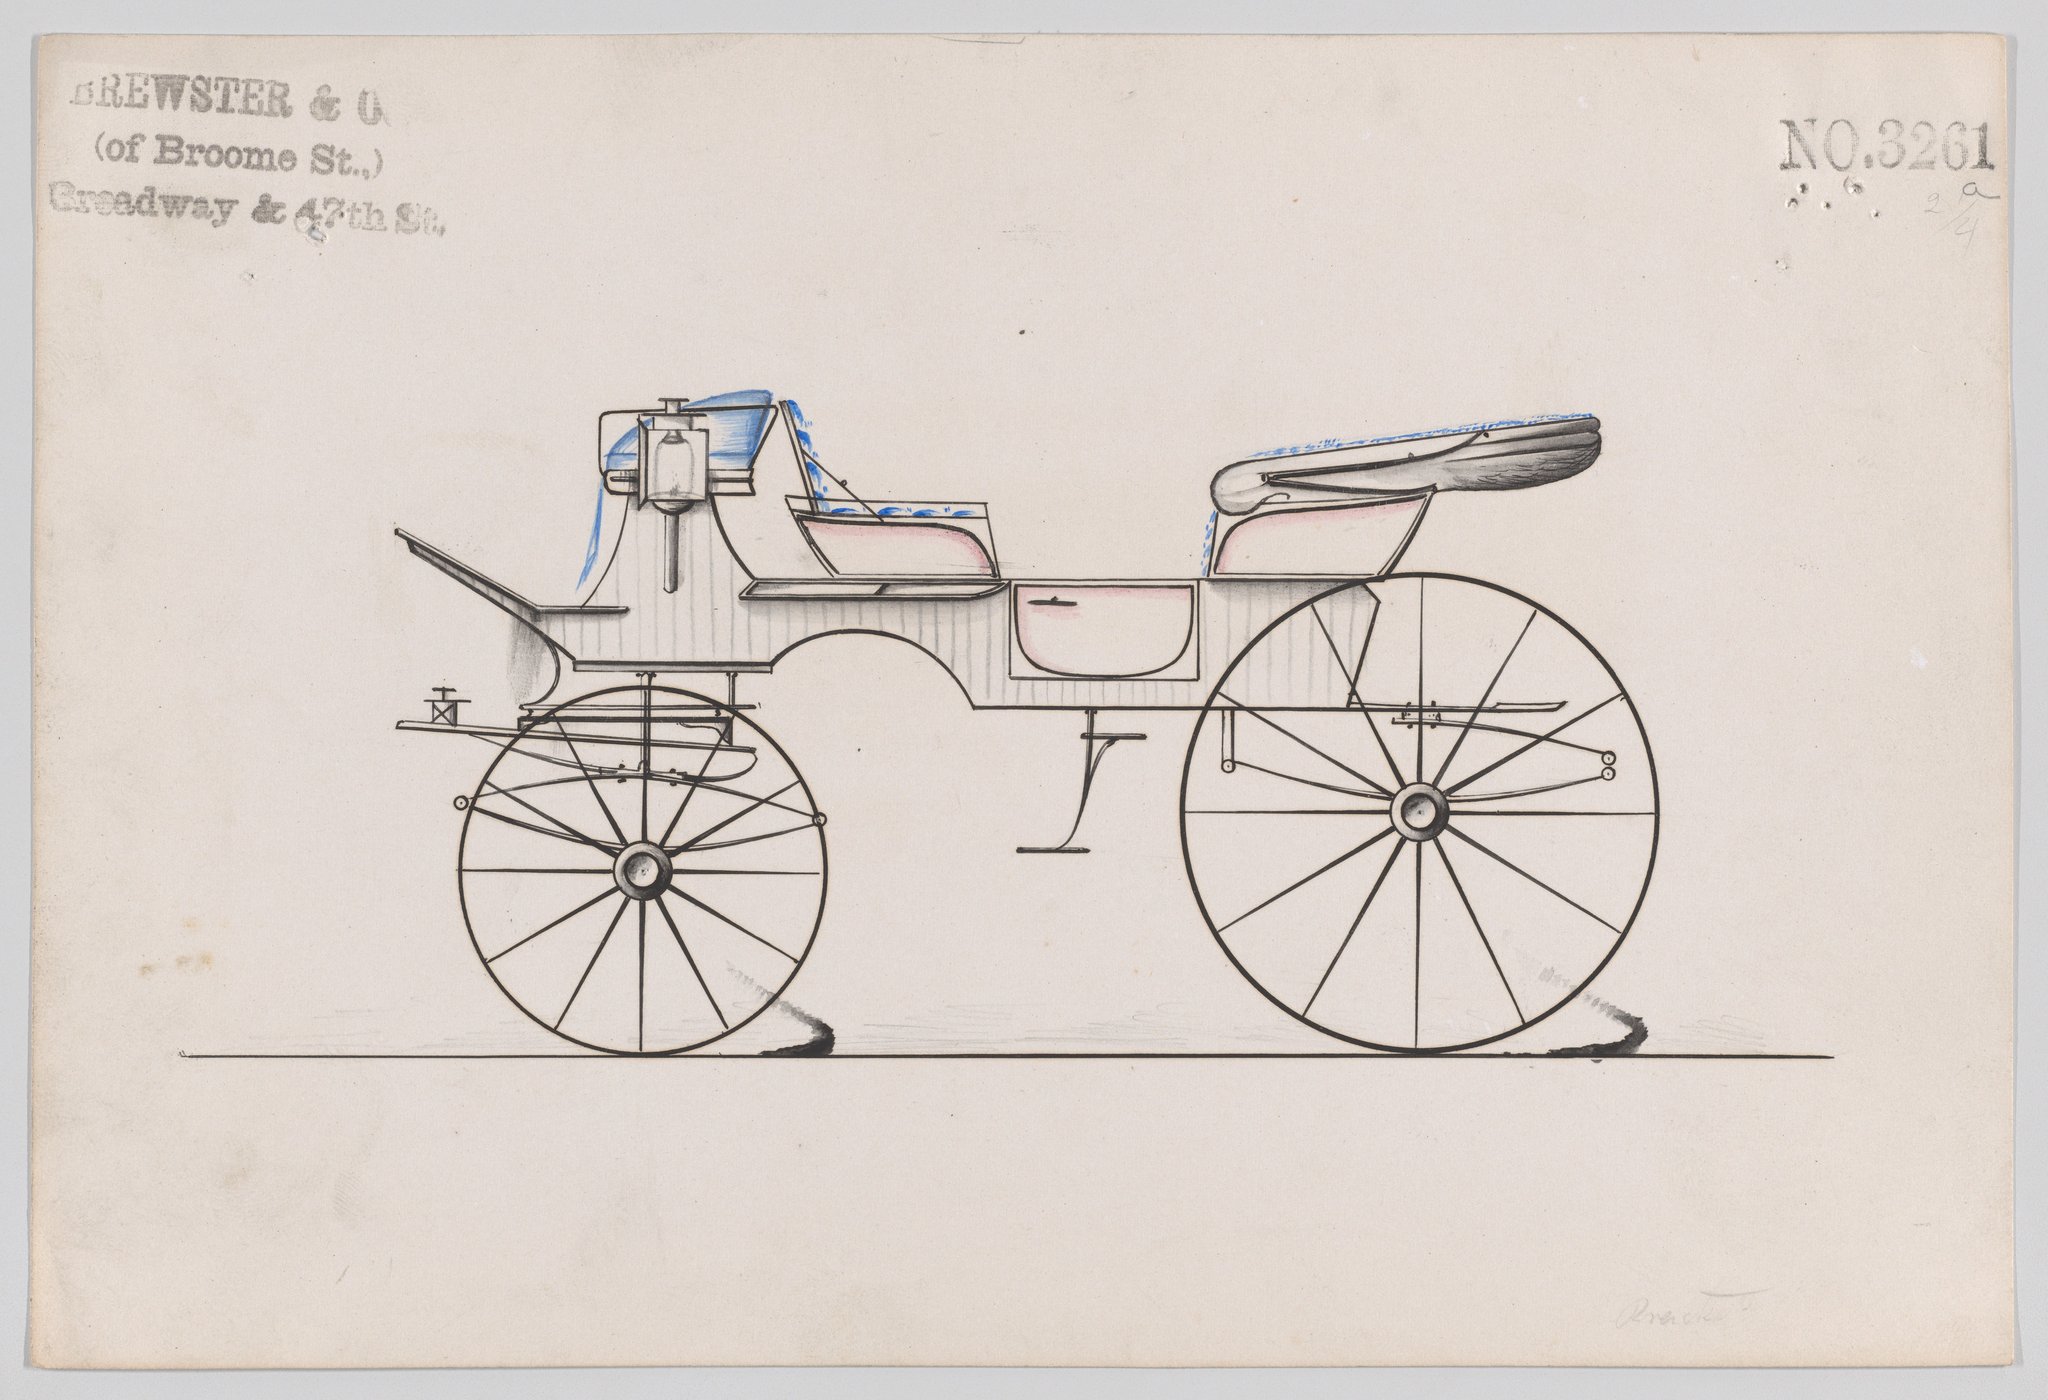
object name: drawing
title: Drag #3261a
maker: brewster & co.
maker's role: manufacturer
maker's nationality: american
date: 1876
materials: gouache, watercolor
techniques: pen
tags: carriages